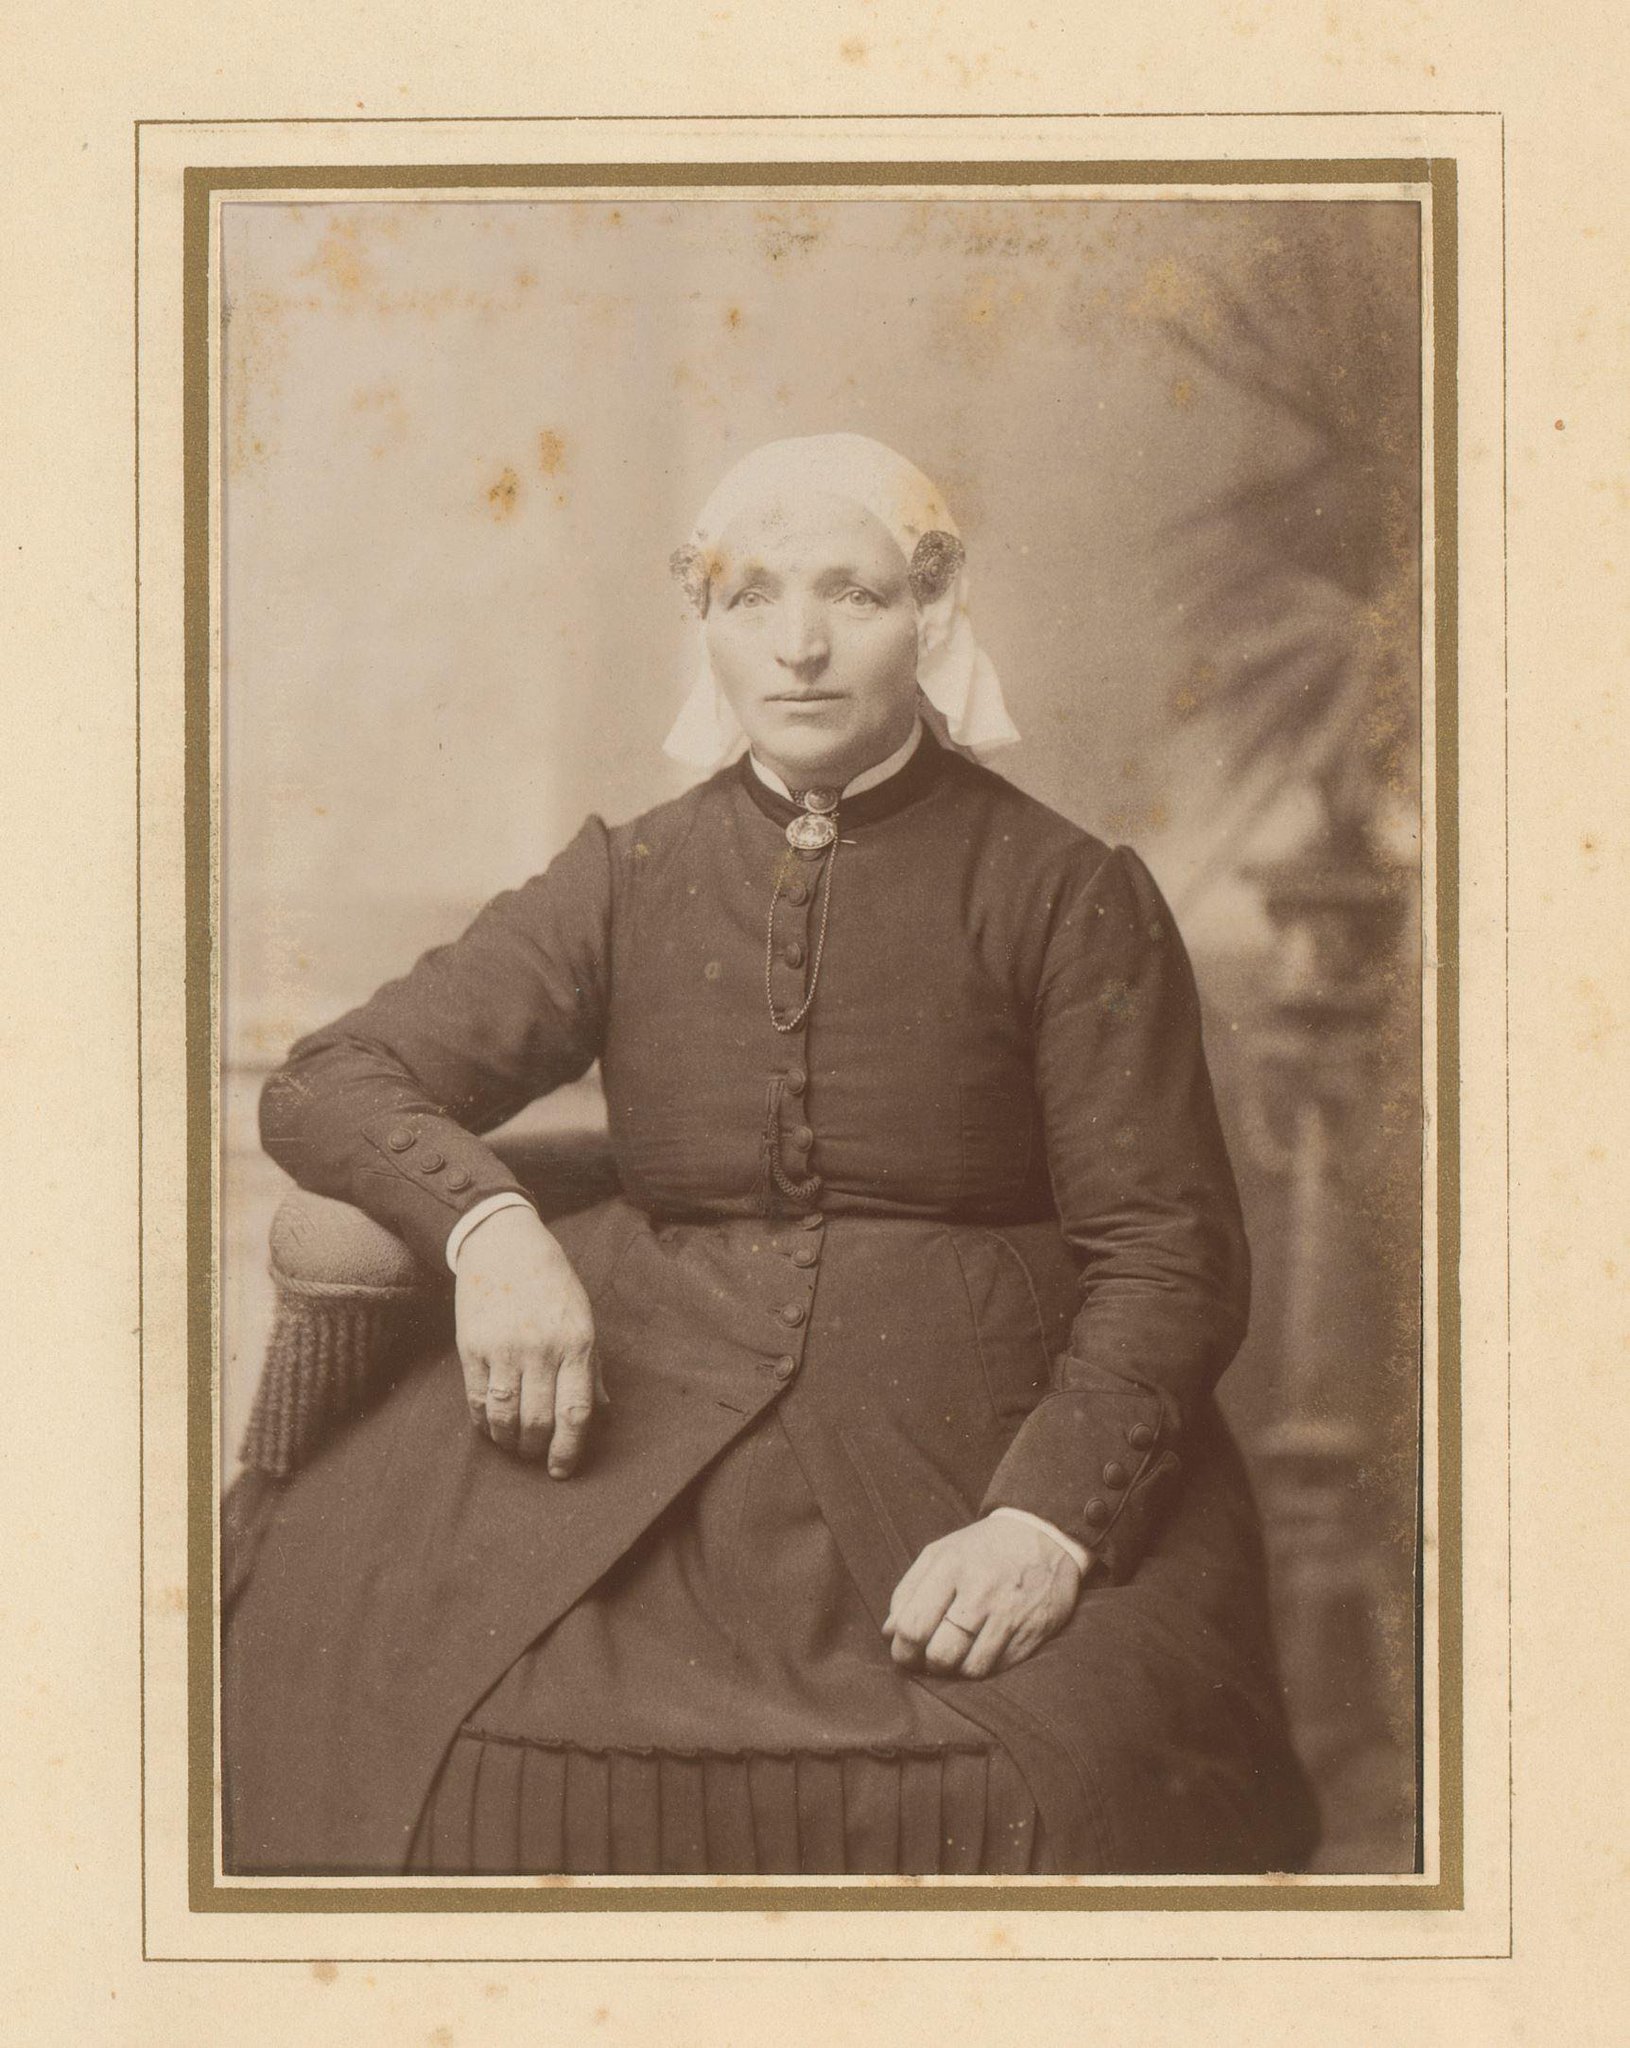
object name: photograph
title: Portret van een zittende vrouw met witte klederdrachtmuts en oorijzers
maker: thomas martin staas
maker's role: fotograaf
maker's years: 1844-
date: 1865-1895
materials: cardboard, photographic support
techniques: albumen print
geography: leeuwarden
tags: sitting figure - aa - female human figure, historical persons - bb - woman, head-gear: cap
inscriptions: inscription: ‘Th. M. Staas/ HOFPHOTOGRAAF./ Leeuwarden/ Willemskade W.1.’